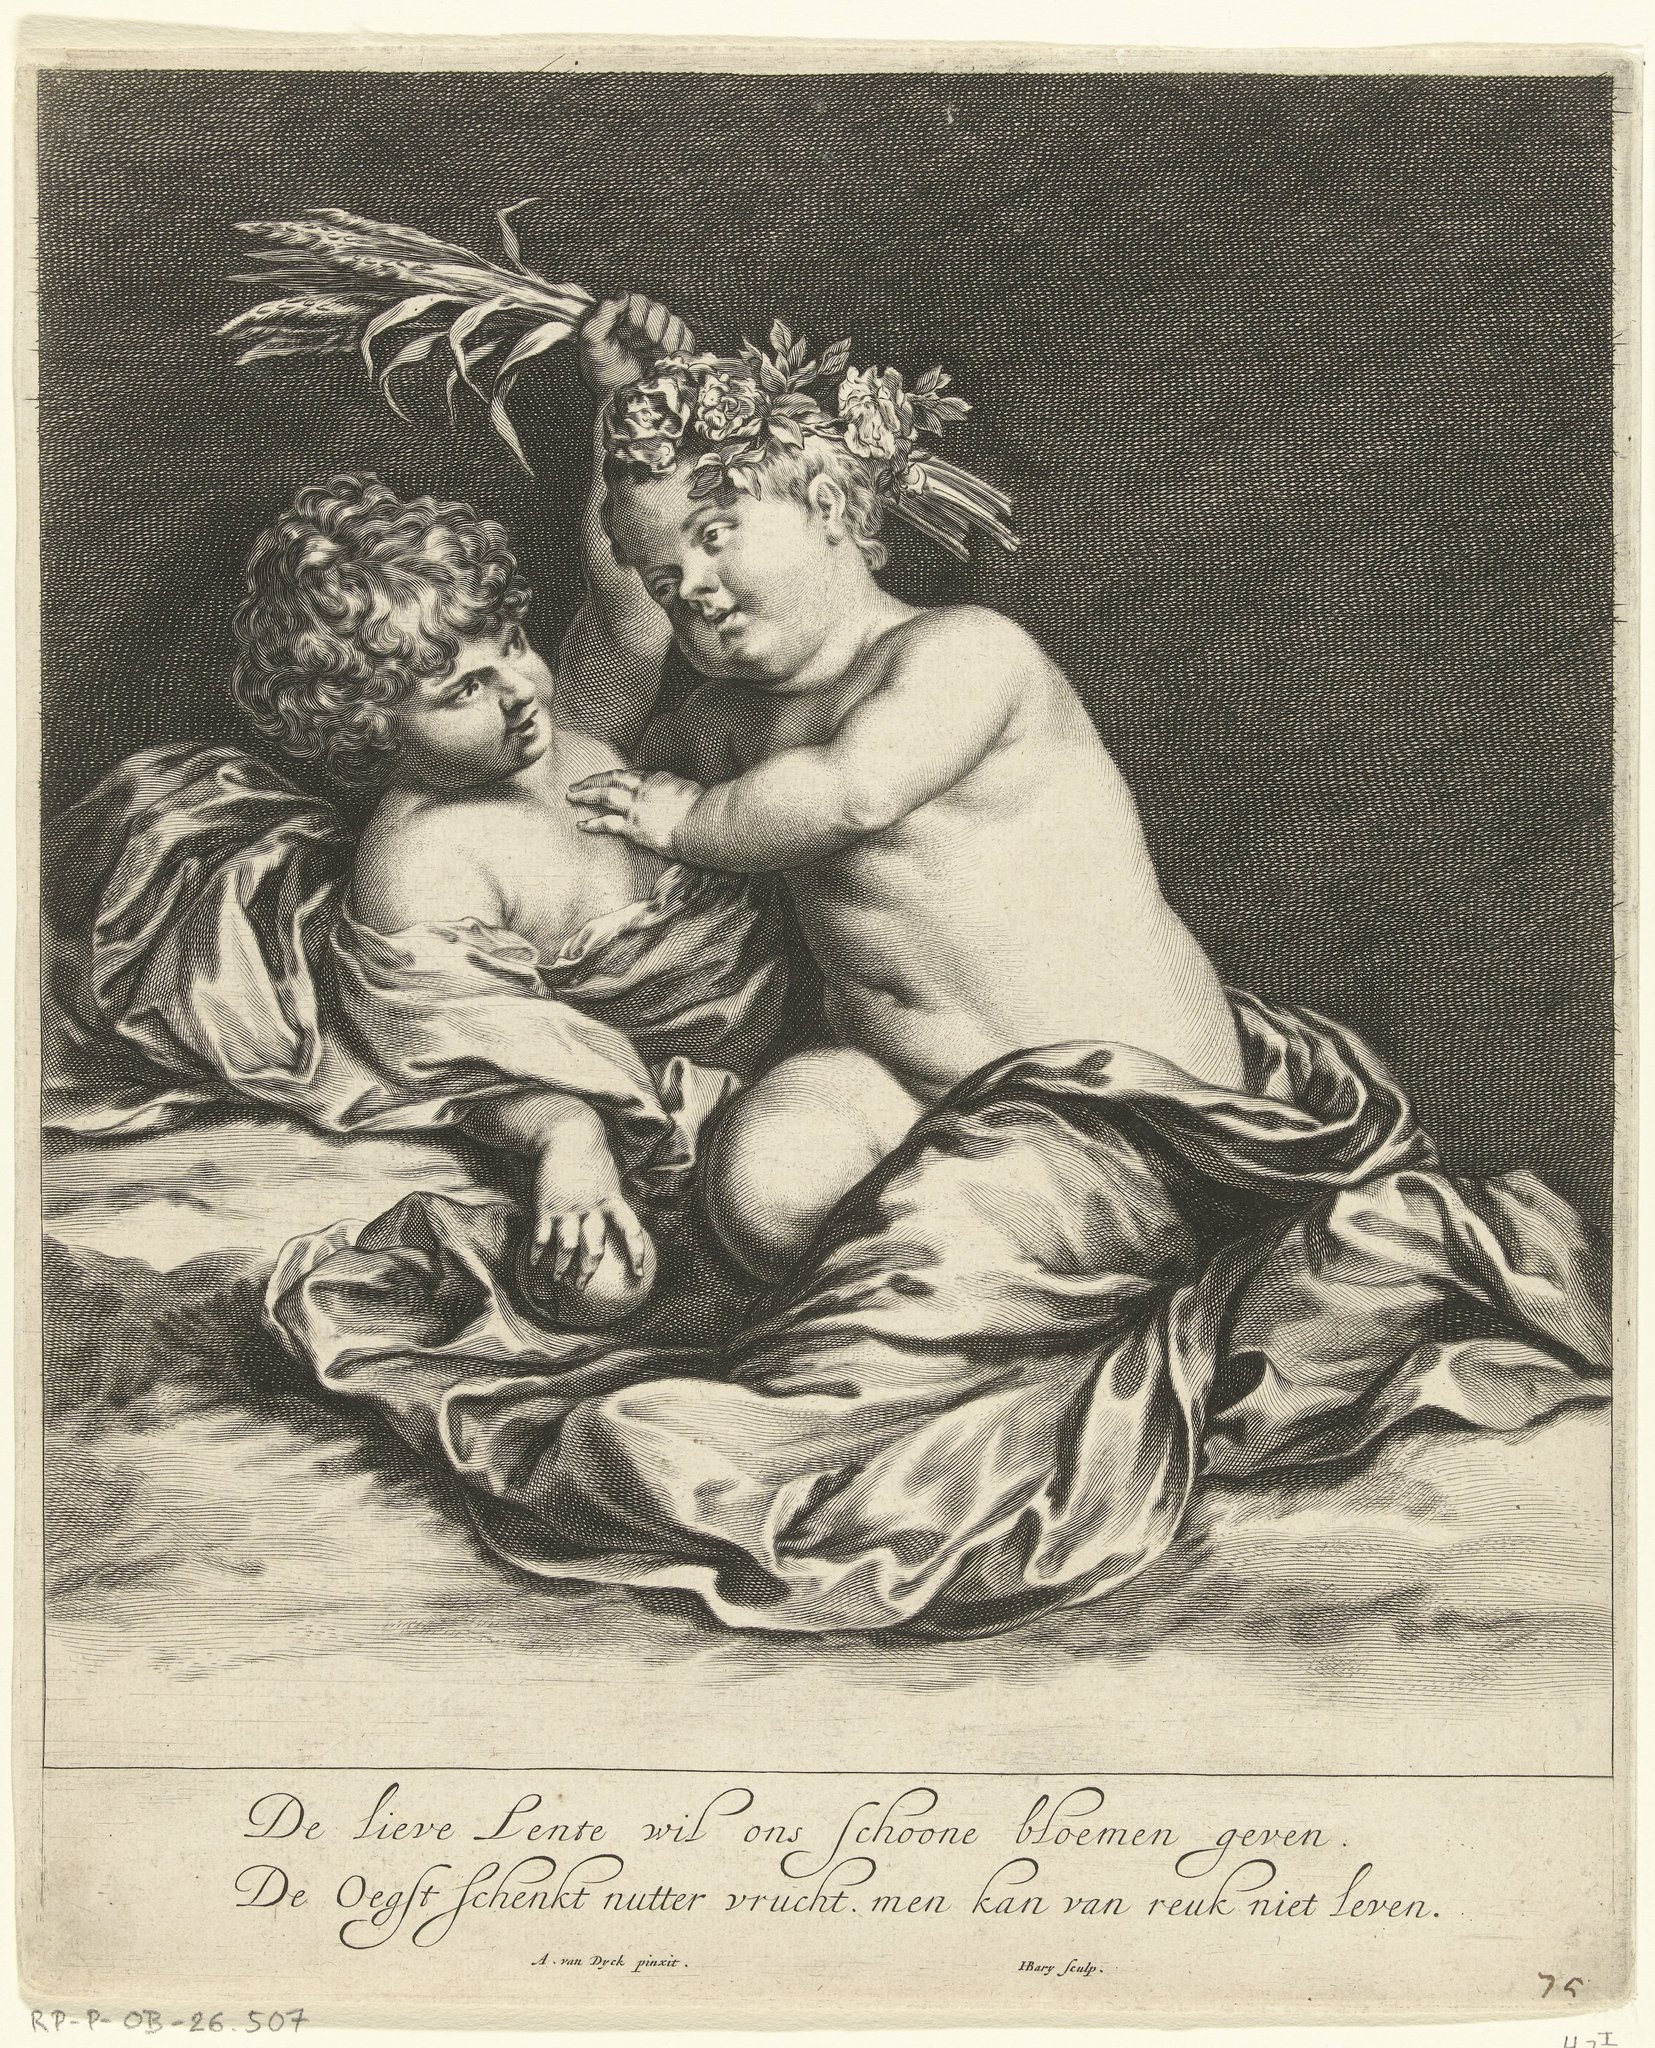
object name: print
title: Twee spelende kinderen: Lente en Herfst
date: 1657-1677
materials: paper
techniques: engraving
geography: netherlands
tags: spring, 'ver'; 'primavera' (ripa) (+ allegorical or symbolical representation of seasons and months), autumn, fall, 'autumnus'; 'autunno' (ripa) (+ allegorical or symbolical representation of seasons and months)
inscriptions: collector's mark: Lugt 240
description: Twee spelende kinderen, links de Herfst met een vrucht en koren, rechts de Lente met een bloemenkrans. Onder de voorstelling een vers van twee regels in het Nederlands.